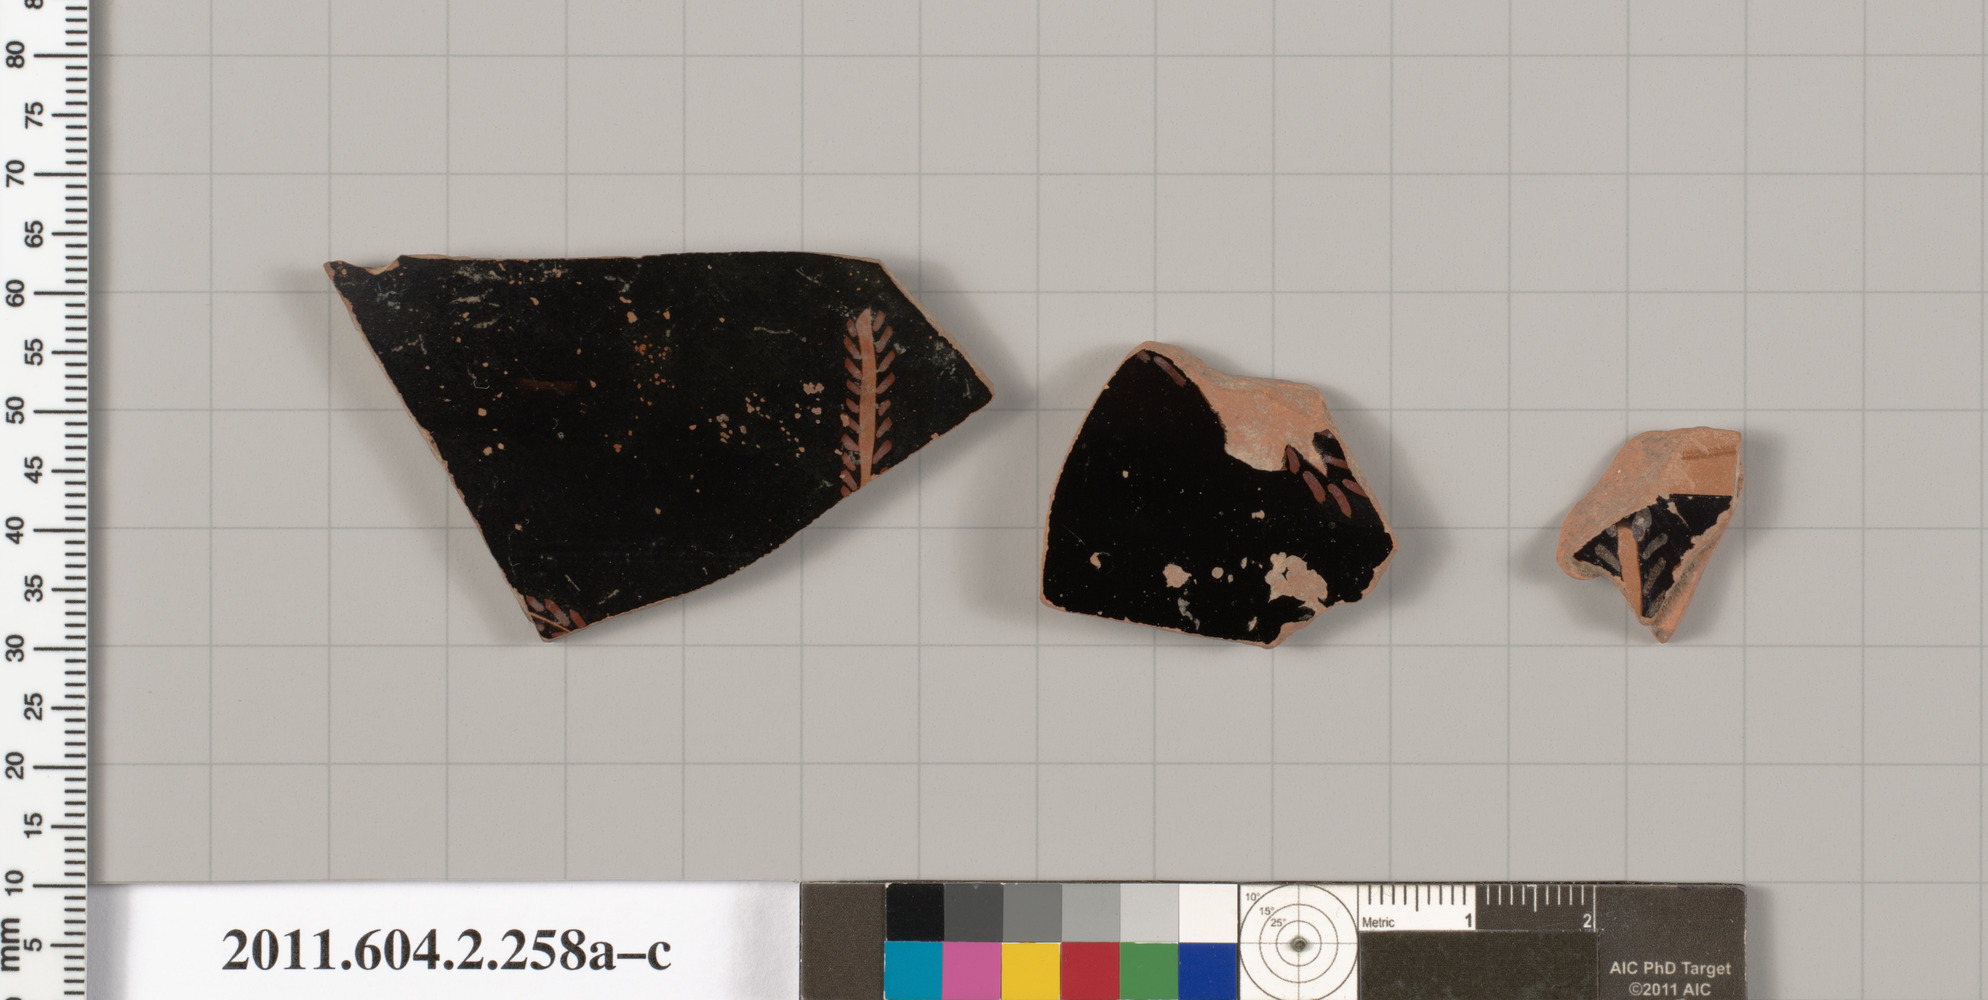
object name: stamnoi fragment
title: Terracotta fragments of stamnoi (jars)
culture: greek, attic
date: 490-470 BCE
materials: terracotta